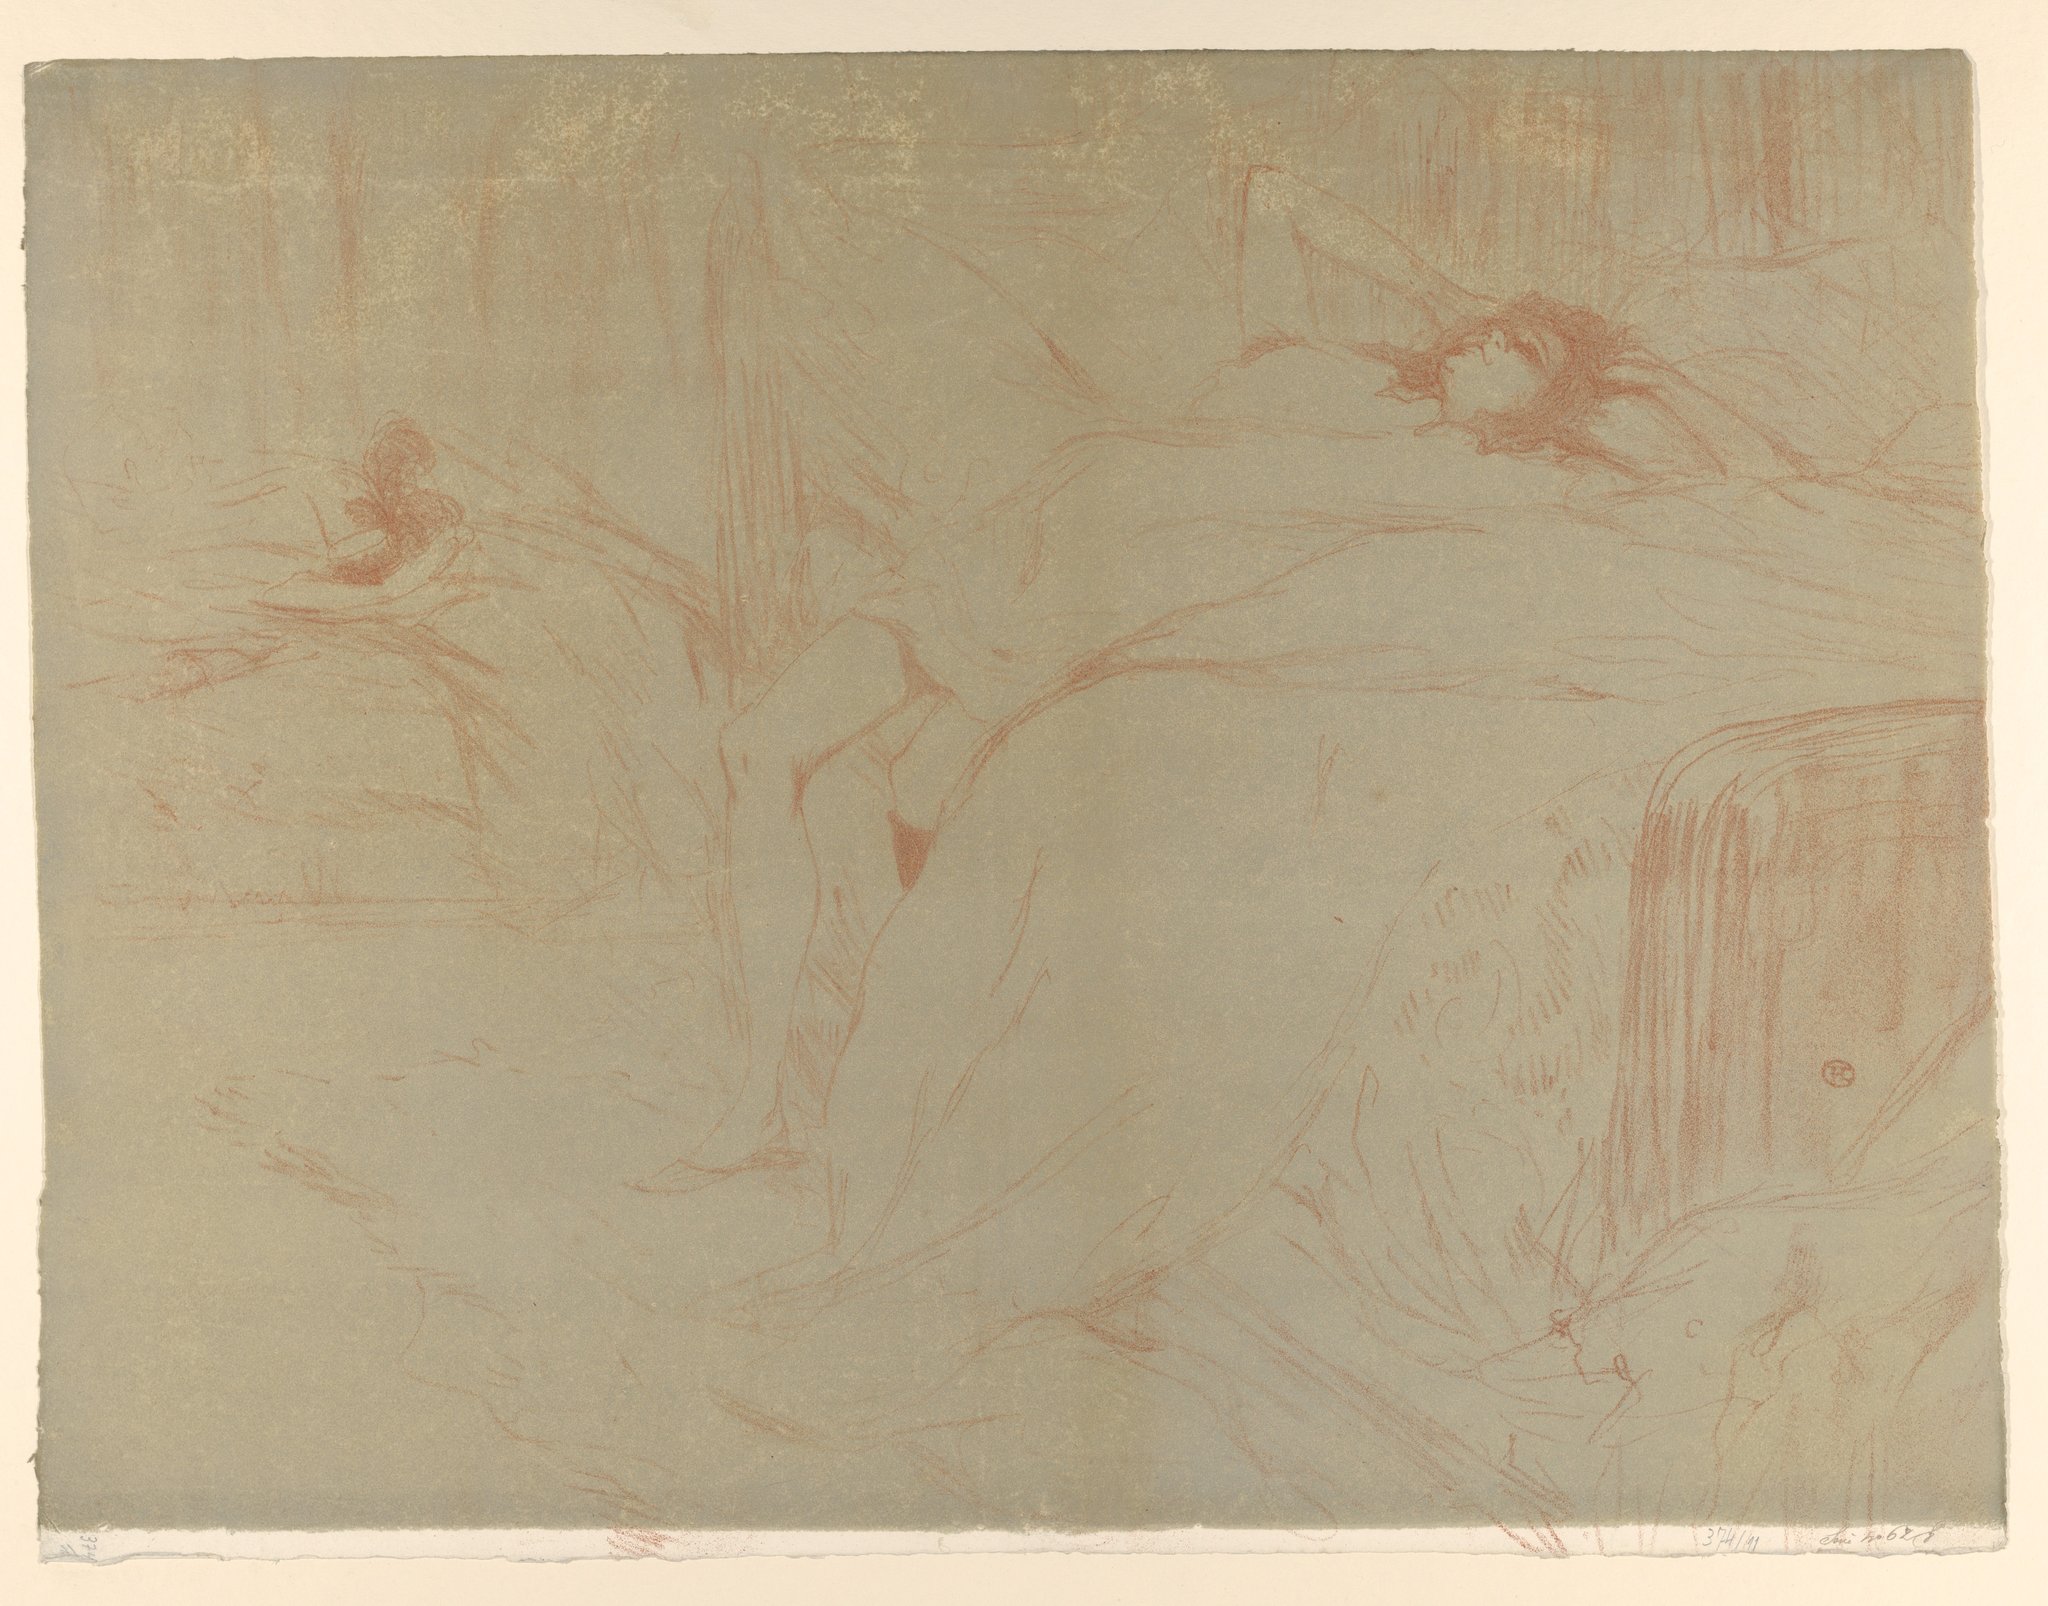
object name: print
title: Collapsed on the Bed, from "Elles"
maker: henri de toulouse-lautrec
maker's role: artist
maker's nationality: french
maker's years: 1864-1901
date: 1896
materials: paper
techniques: lithograph, printing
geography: france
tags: women,beds